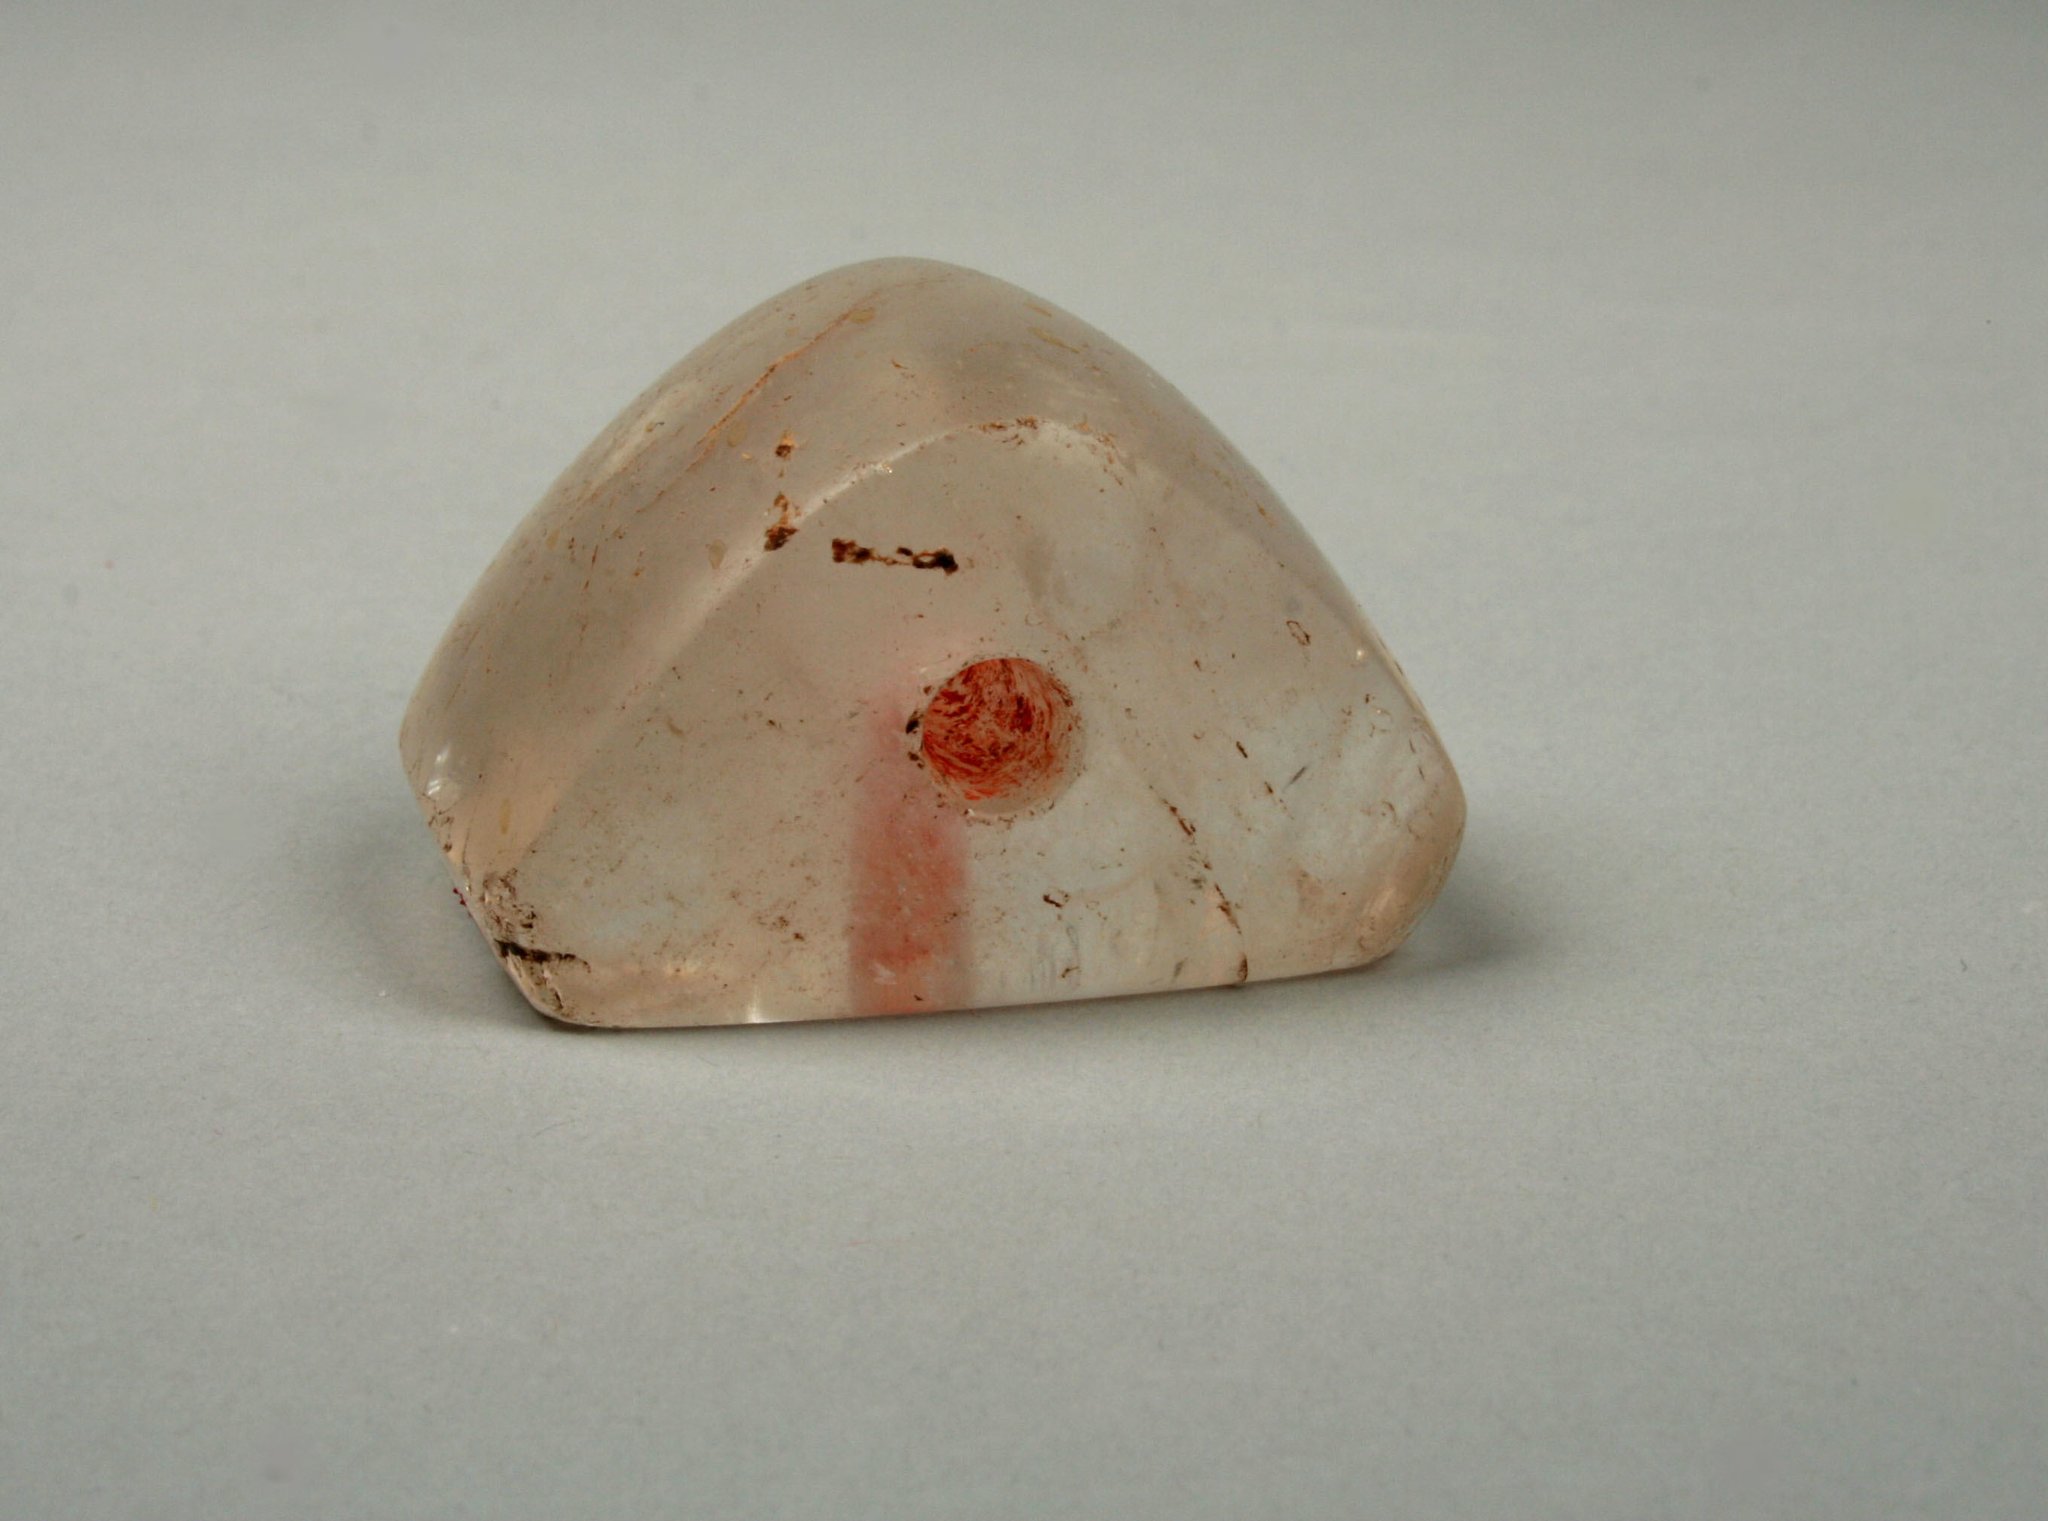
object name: ritual stone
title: Ritual Stone (pulidor)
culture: olmec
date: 1200-701 BCE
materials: stone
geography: mexico